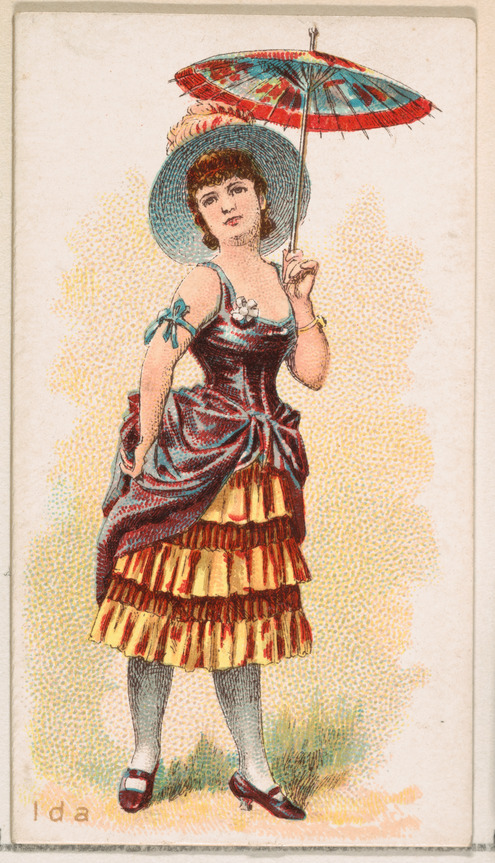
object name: print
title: Ida, from the Ballet Queens series (N182) issued by Wm. S. Kimball & Co.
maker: william s. kimball & company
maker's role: publisher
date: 1889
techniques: color lithograph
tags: women